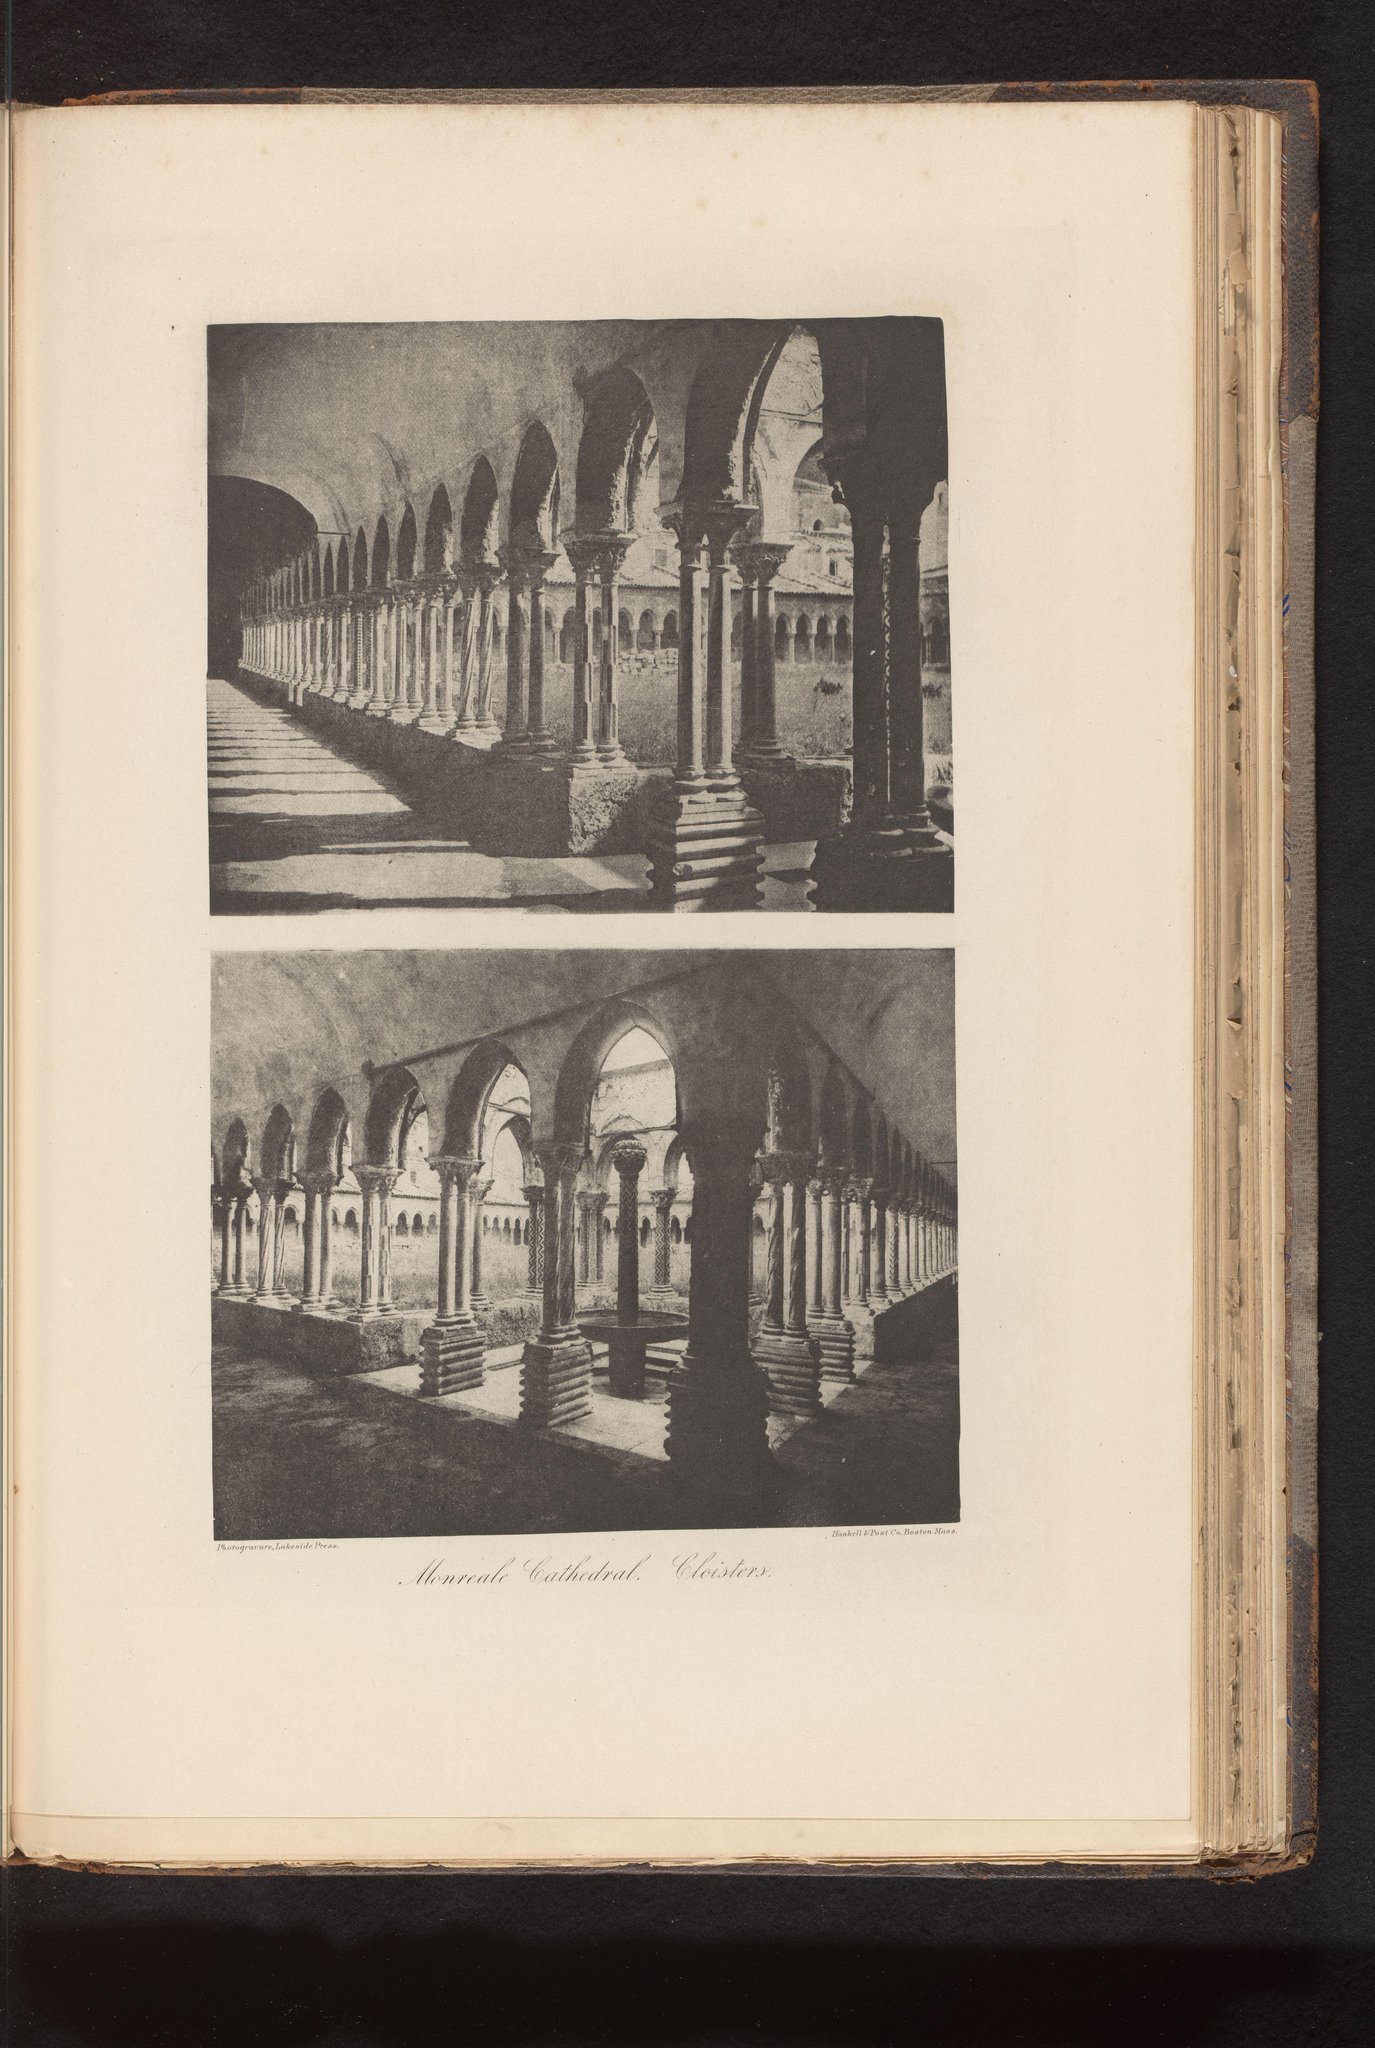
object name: photomechanical print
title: Twee gezichten op de gangen van het klooster bij de kathedraal van Monreale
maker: Anonymous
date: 1881-1886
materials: paper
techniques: photograph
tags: cloisters ~ monastery